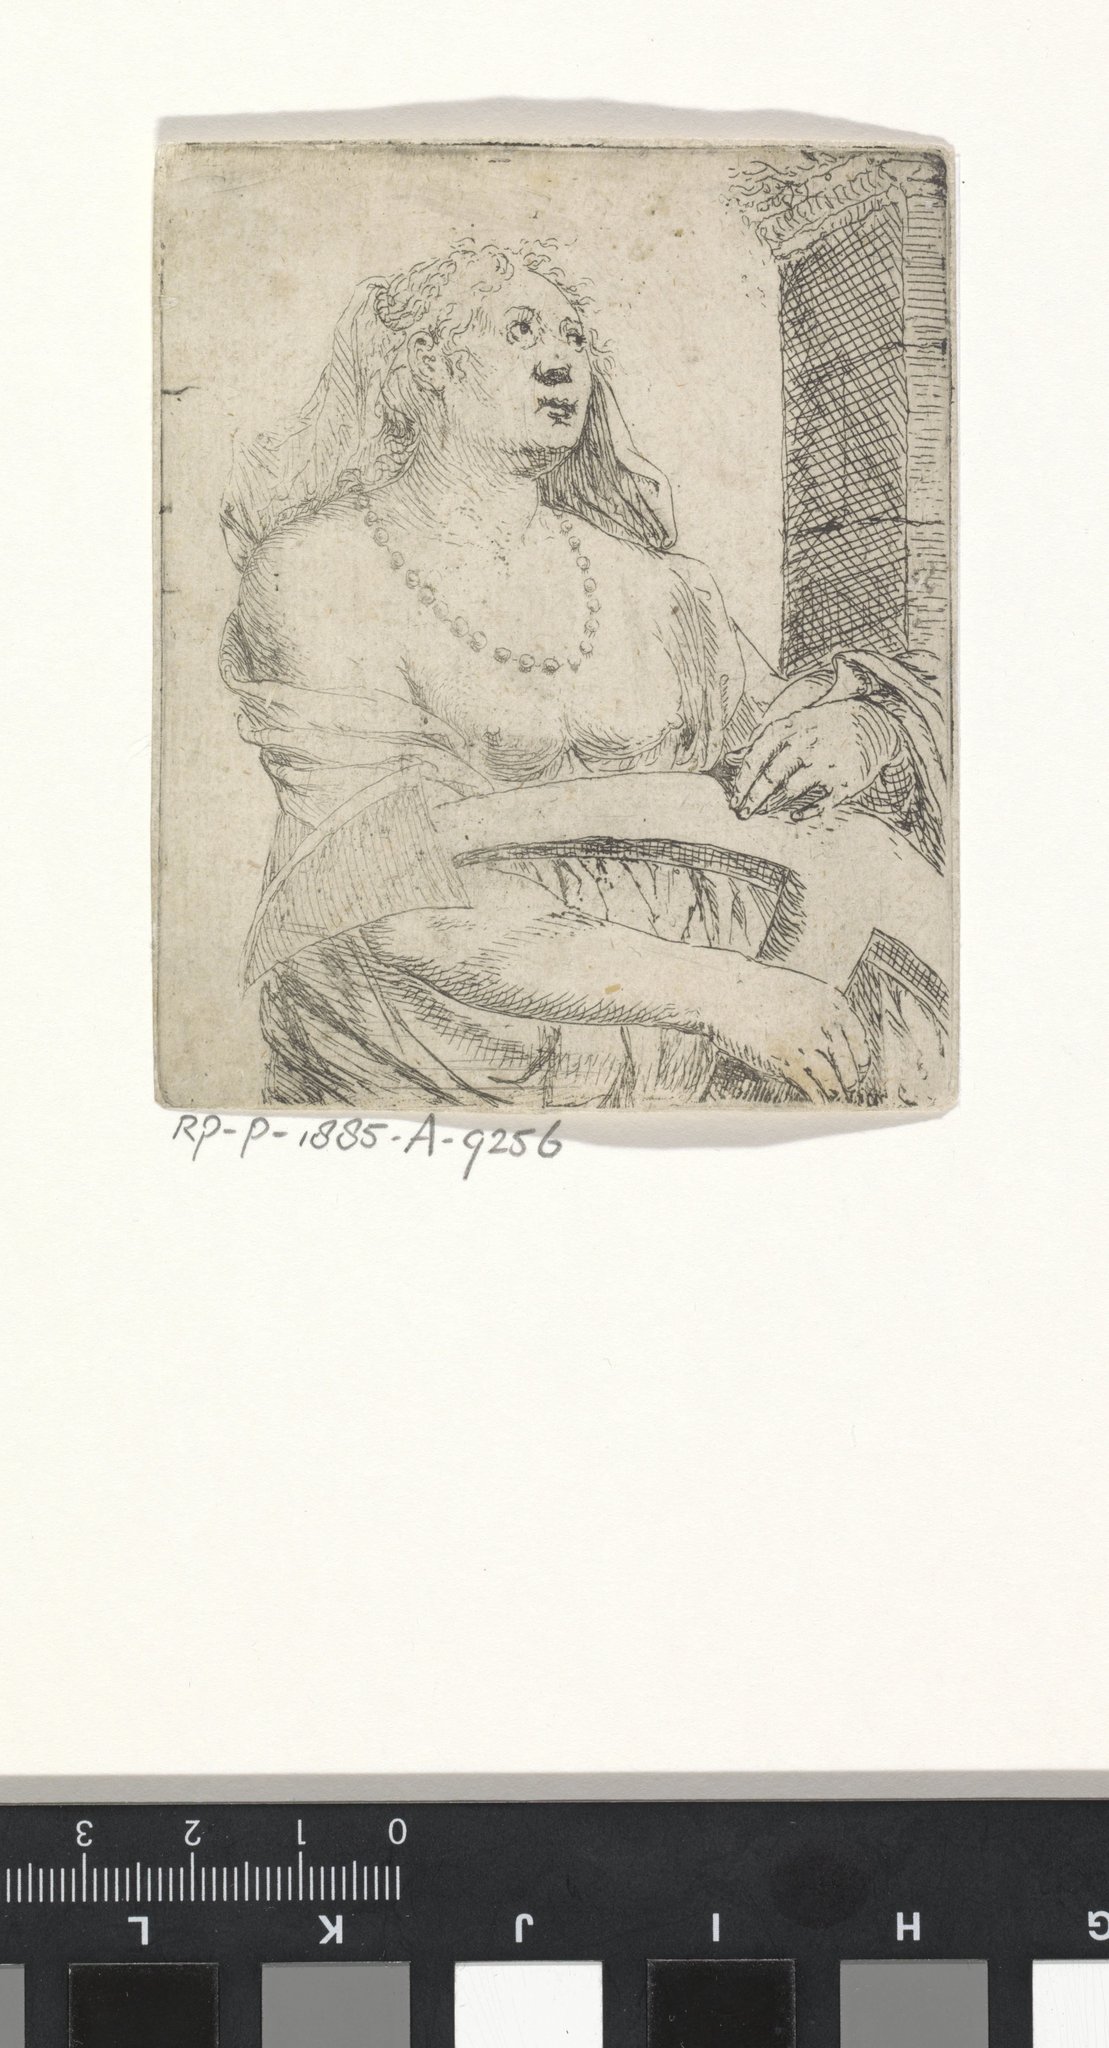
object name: print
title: Personificatie van de Hoop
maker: Anonymous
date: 1600-1700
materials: paper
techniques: etching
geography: netherlands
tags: hope, 'spes'; 'speranza divina e certa' (ripa) ~ one of the three theological virtues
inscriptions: collector's mark: Lugt 2228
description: De gepersonifieerde Hoop kijkt omhoog, met ontblote borst en een anker in haar handen.